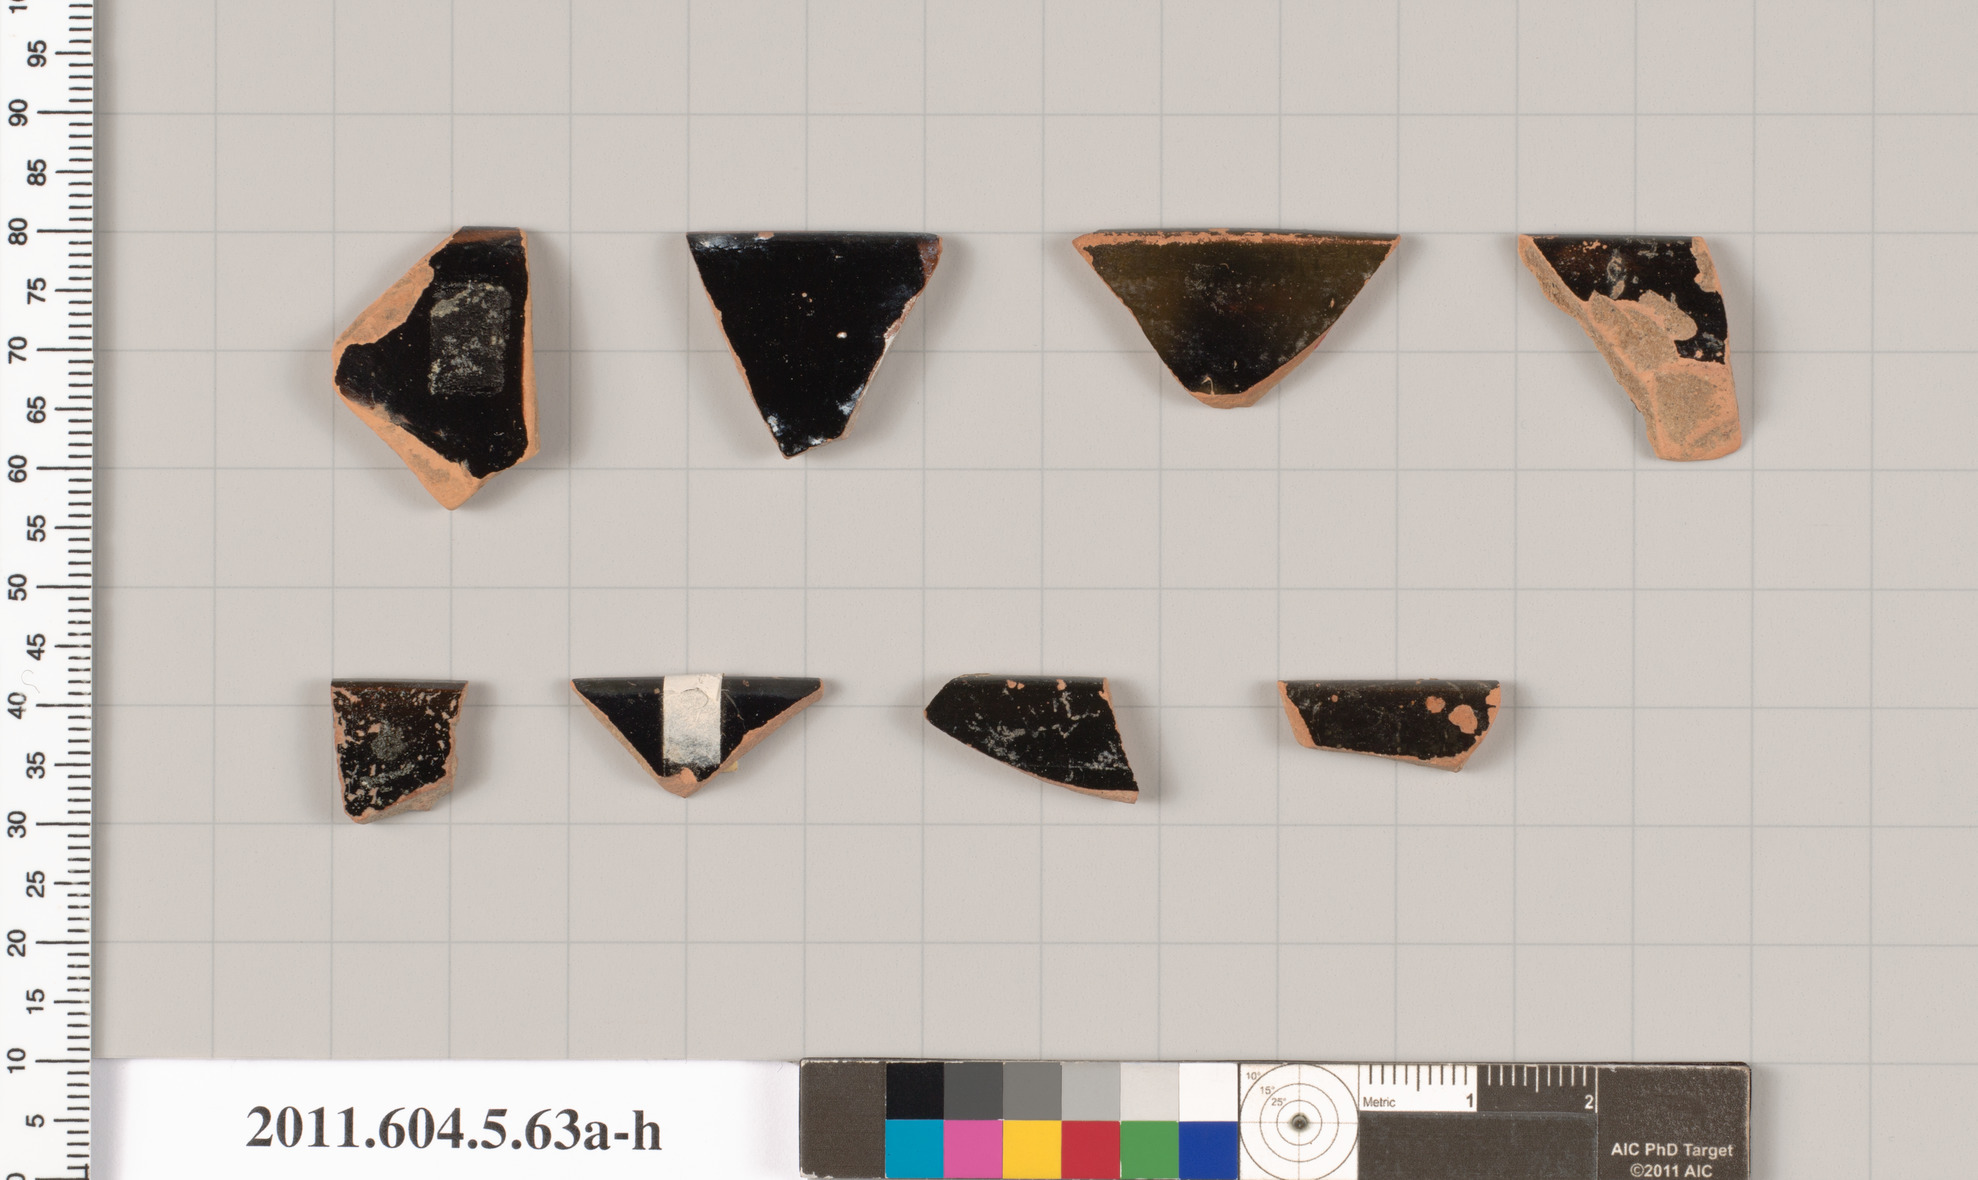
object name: kylix fragment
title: Terracotta rim fragments of kylikes (drinking cups)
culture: greek, attic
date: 500-401 BCE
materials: terracotta